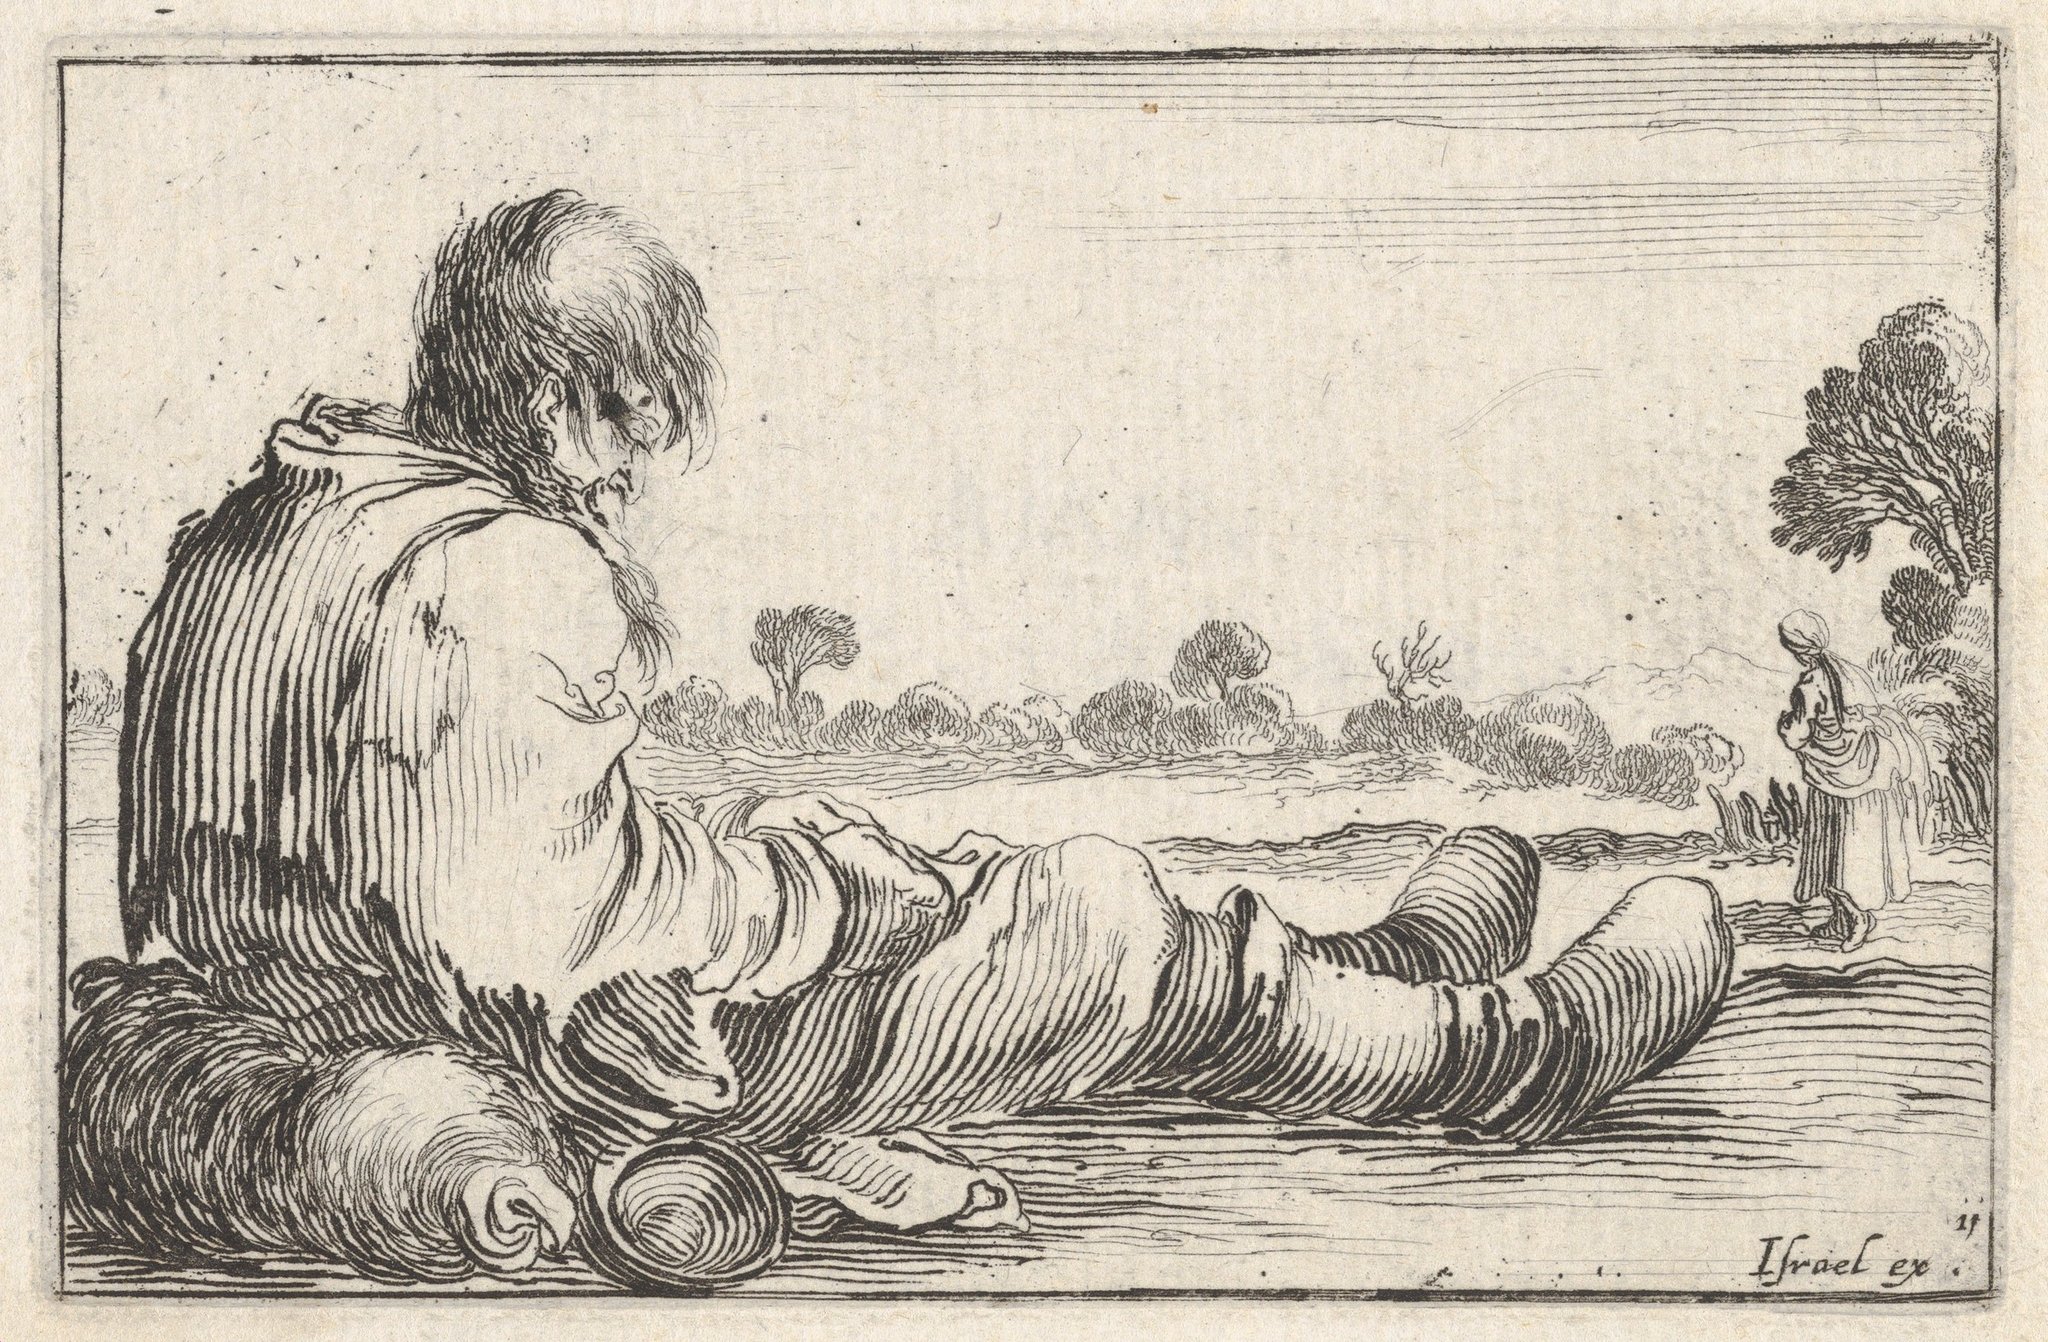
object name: print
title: Plate 11: An old man sitting on the ground to left, seen from behind, a peasant woman seen from behind to right in background, from "Caprice faict par de la Bella"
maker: stefano della bella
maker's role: artist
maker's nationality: italian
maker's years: 1610-1664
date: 1642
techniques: etching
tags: men,women